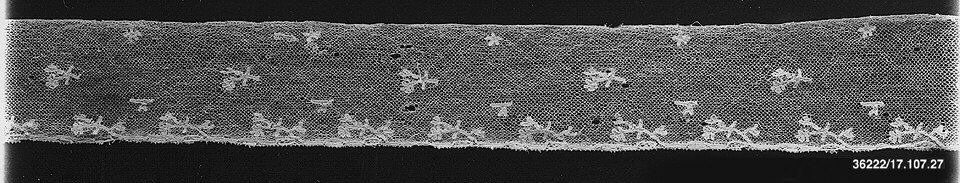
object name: piece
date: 1701-1900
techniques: lace